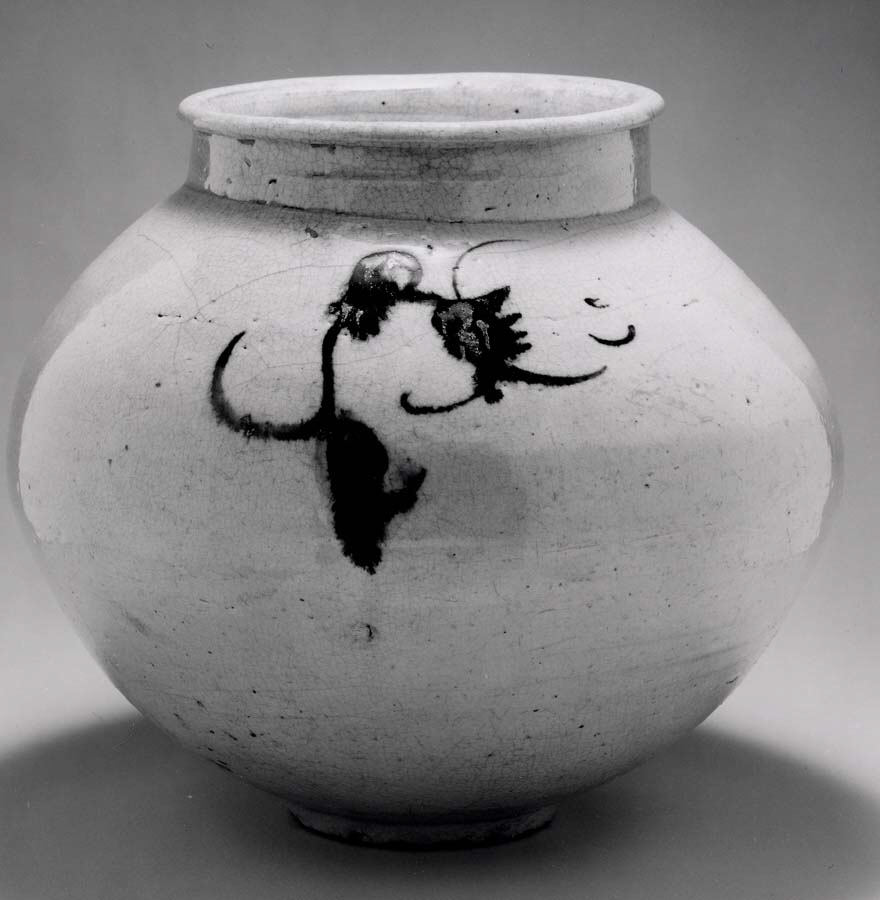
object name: jar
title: Jar with Floral Design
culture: korean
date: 1867-1933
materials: iron, porcelain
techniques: underglaze